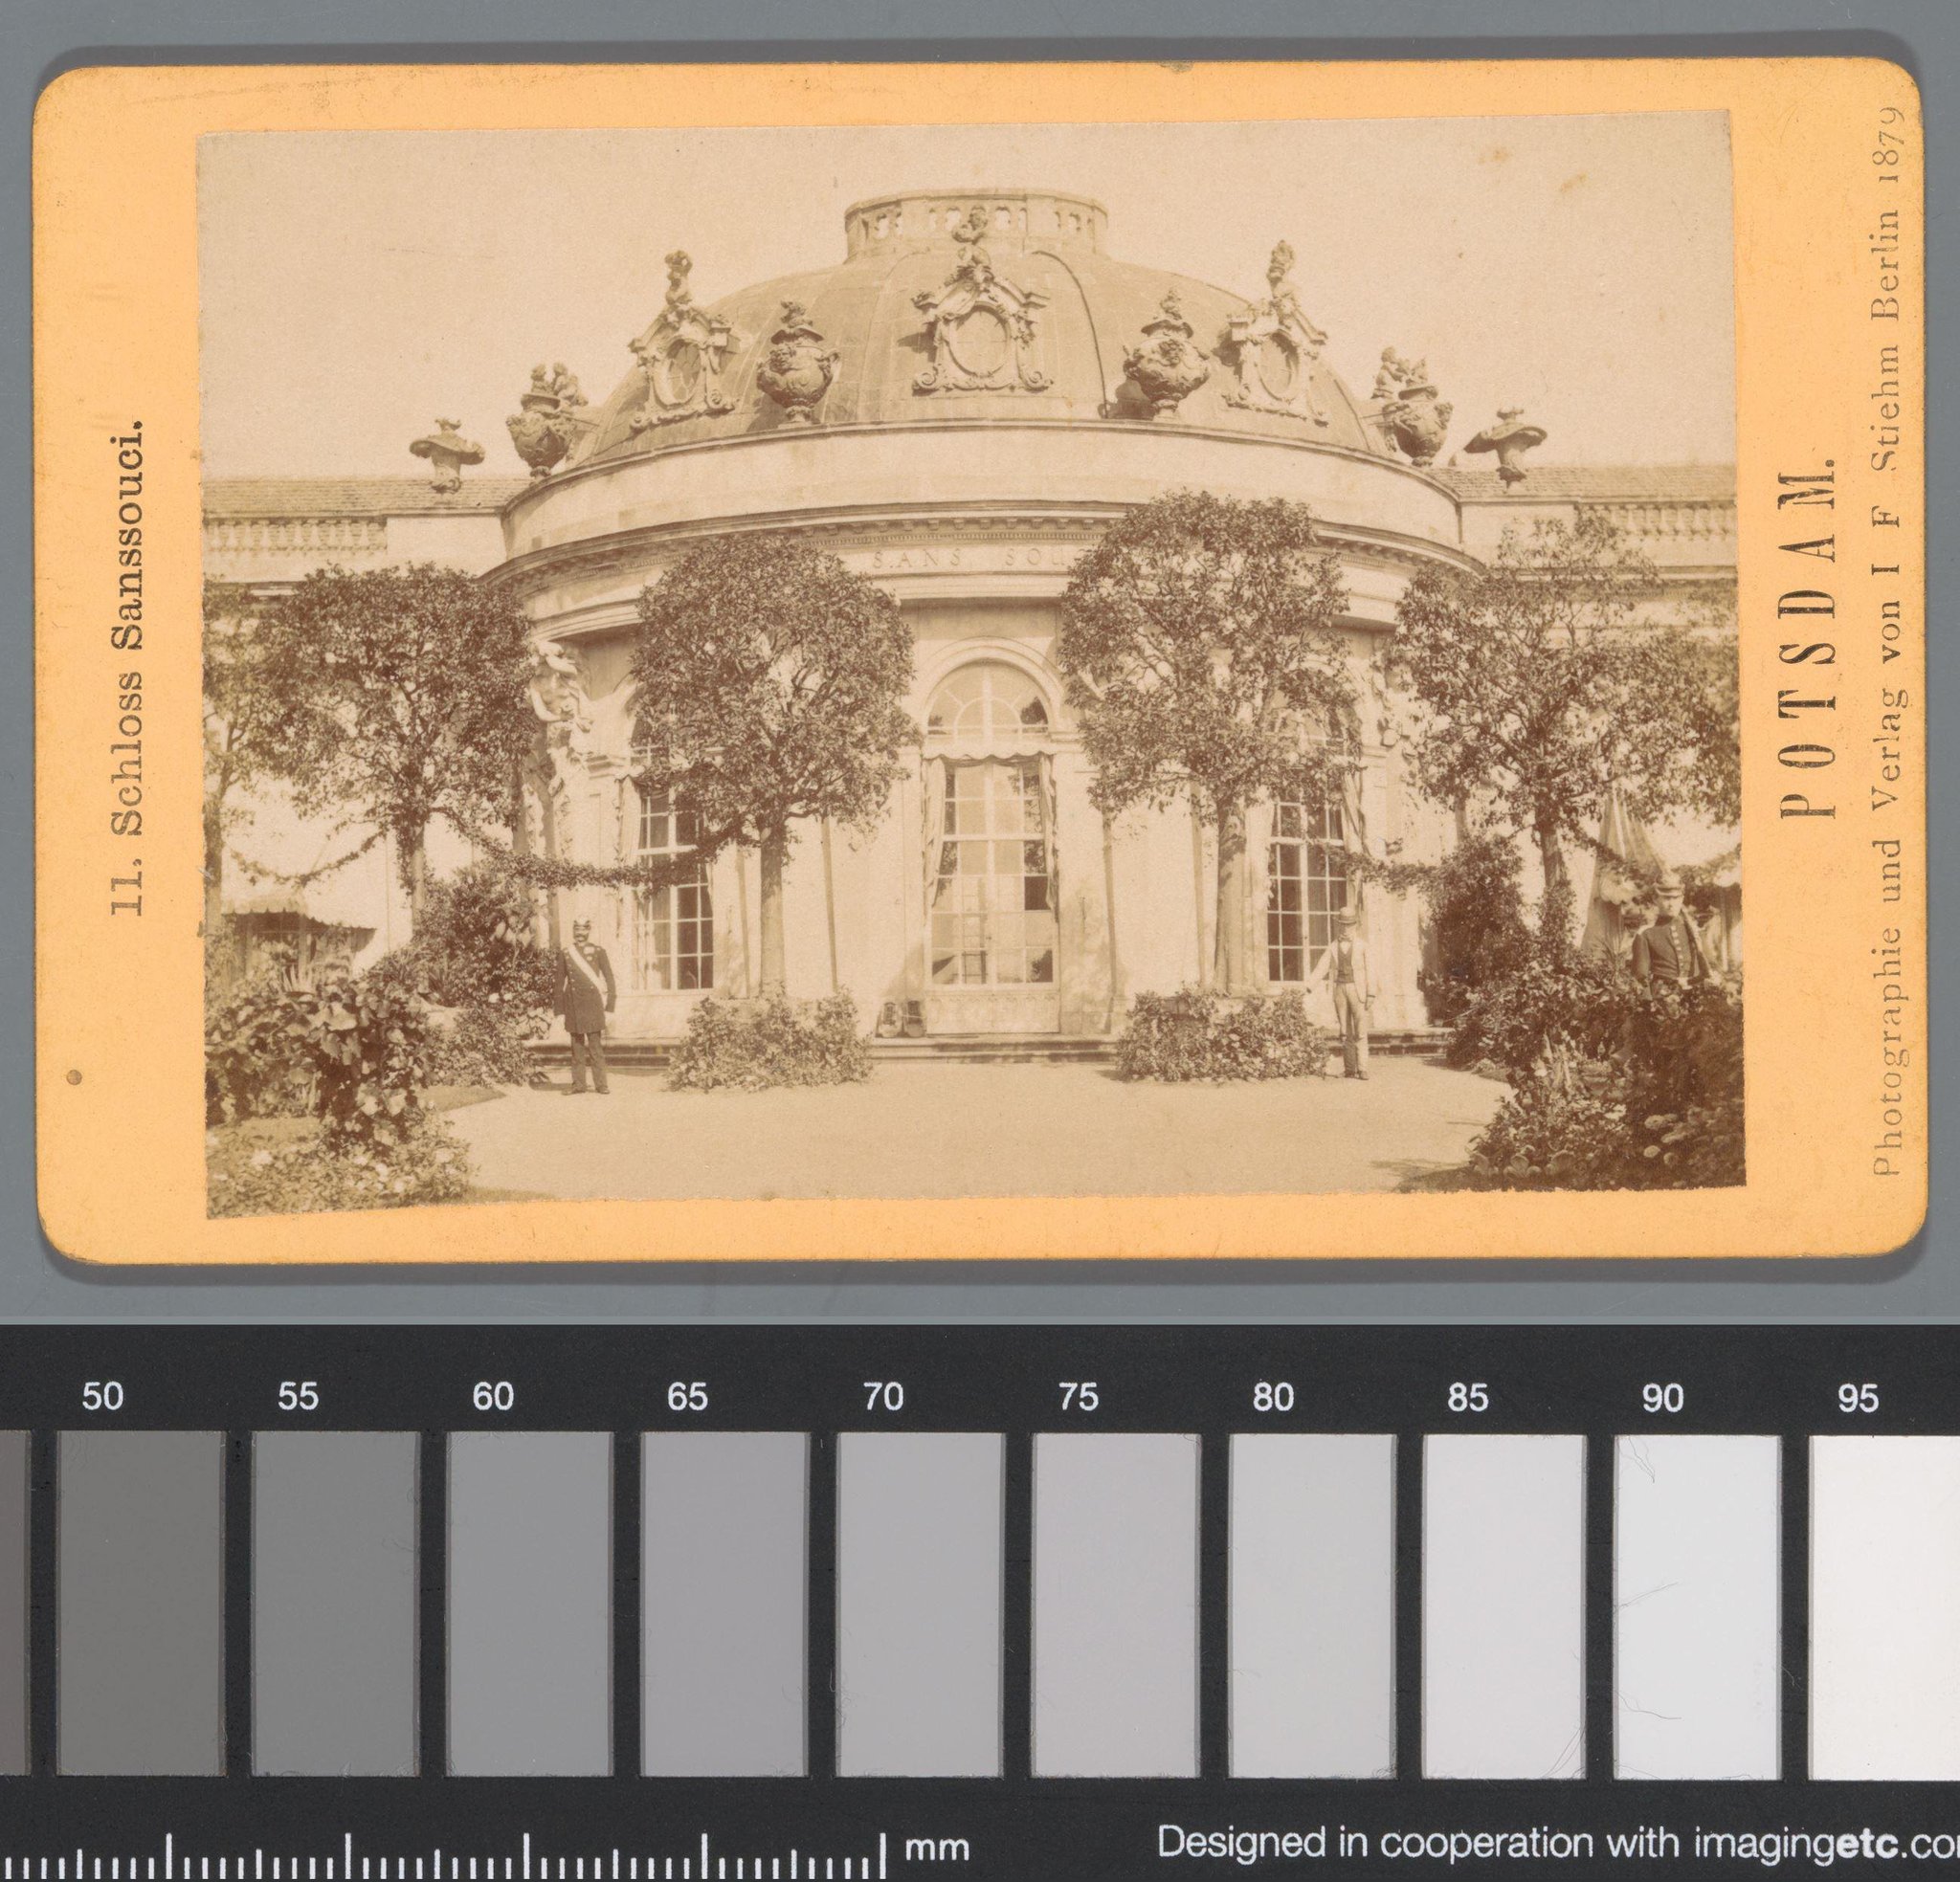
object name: photograph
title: Slot Sanssouci te Potsdam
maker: johann friedrich stiehm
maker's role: fotograaf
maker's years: 1826-1902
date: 1879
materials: cardboard, paper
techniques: albumen print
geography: berlin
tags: palace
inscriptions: number: ‘11.’